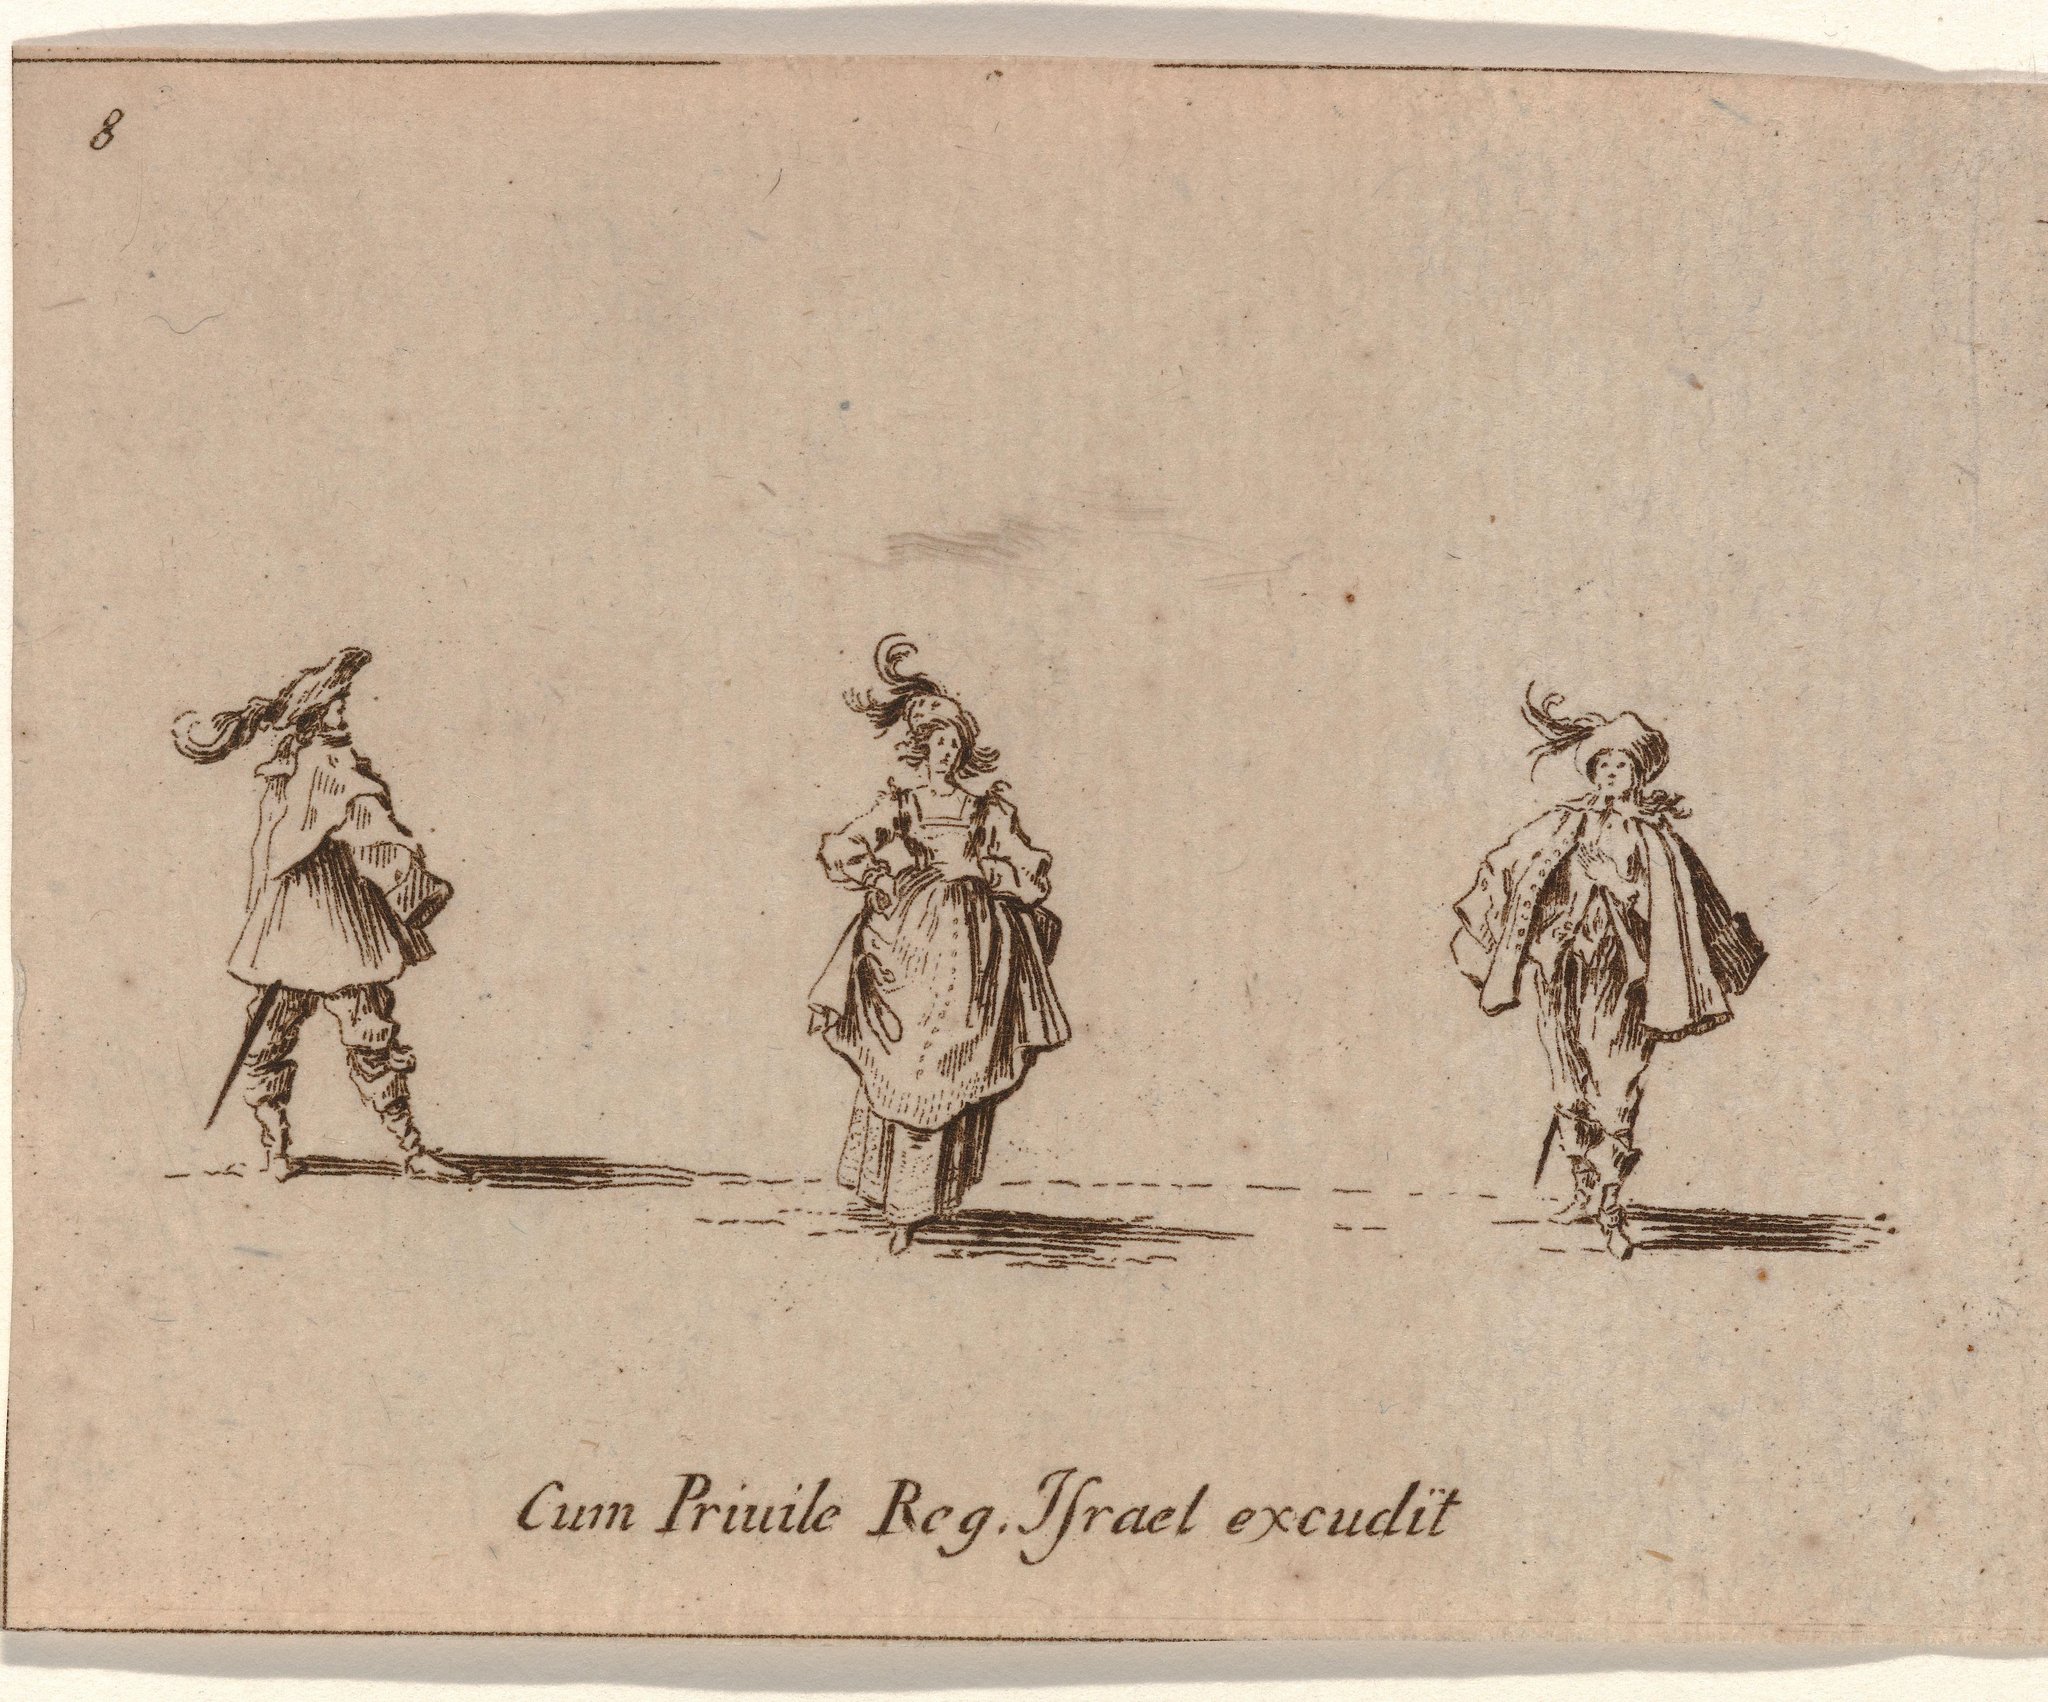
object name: print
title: Drie figuurtjes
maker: israël henriet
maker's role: printer, publisher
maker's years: 1590-1661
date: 1635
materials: paper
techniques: etching